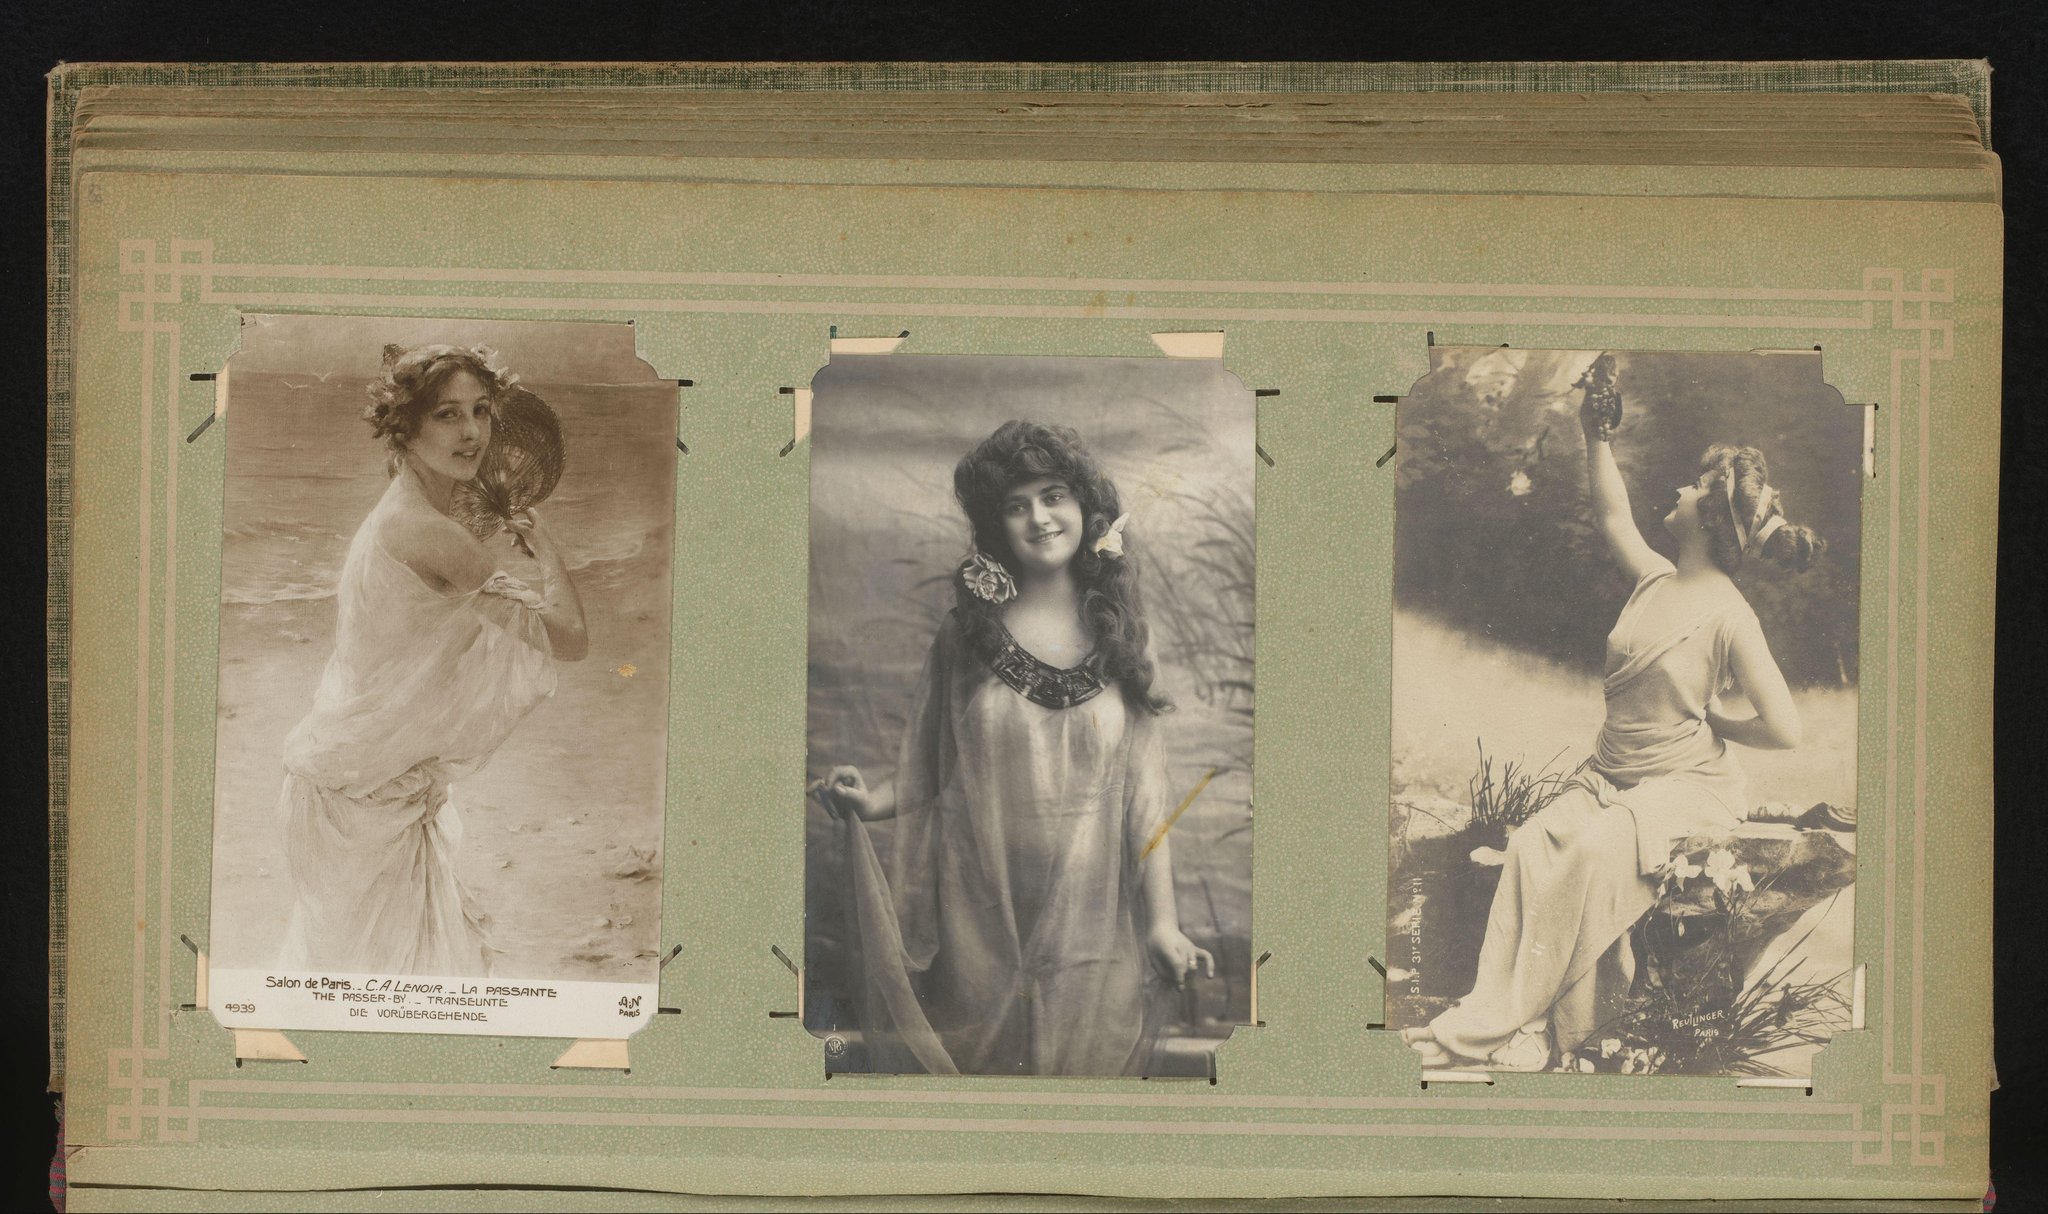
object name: album leaf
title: Fotoreproductie van een geschilderd portret van een vrouw met waaier op het strand door Charles Amable Lenoir en twee portretten van vrouwen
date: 1900-1930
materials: cardboard, photographic support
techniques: gelatin silver print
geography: paris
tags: flowers, historical persons - bb - woman, fan, beach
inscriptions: monogram: ‘AN/ PARIS’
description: Deze foto's maken deel uit van een album.